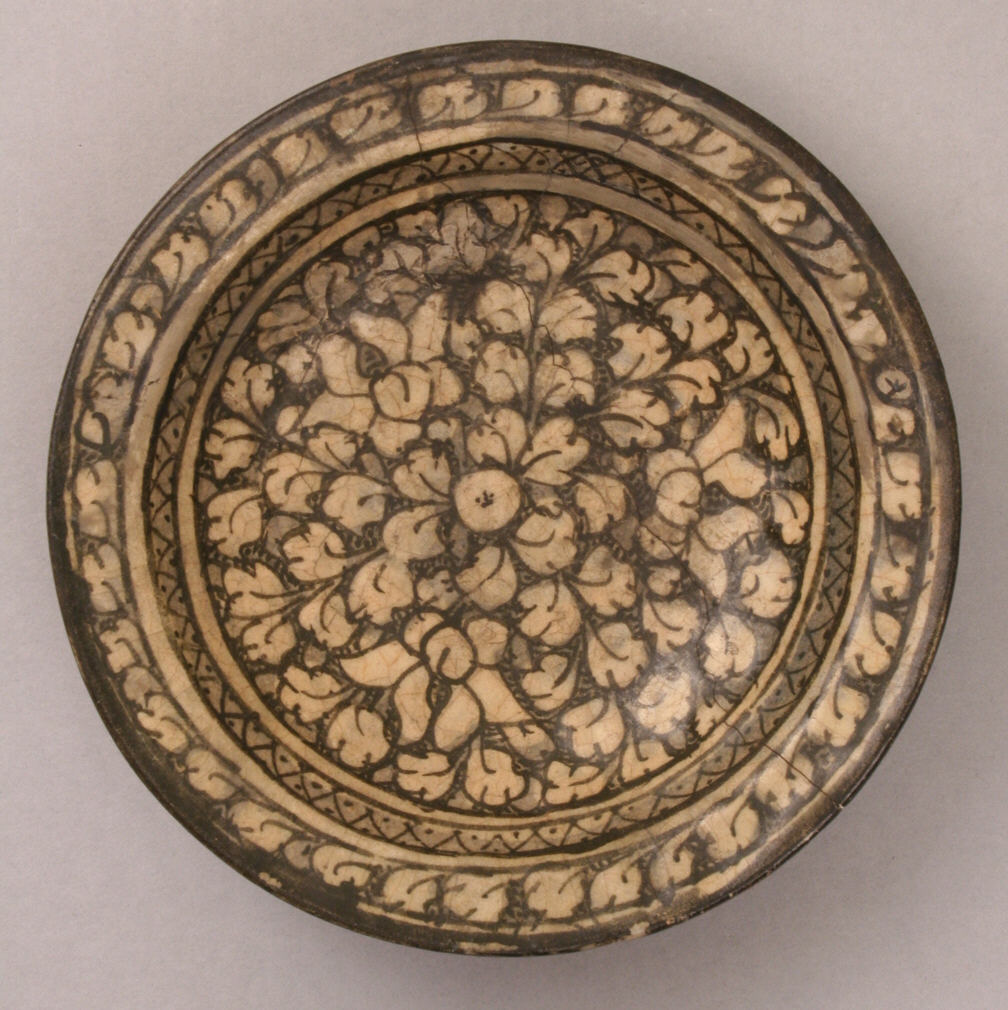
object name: dish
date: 1301-1400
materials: stonepaste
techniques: painting, underglaze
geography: iran